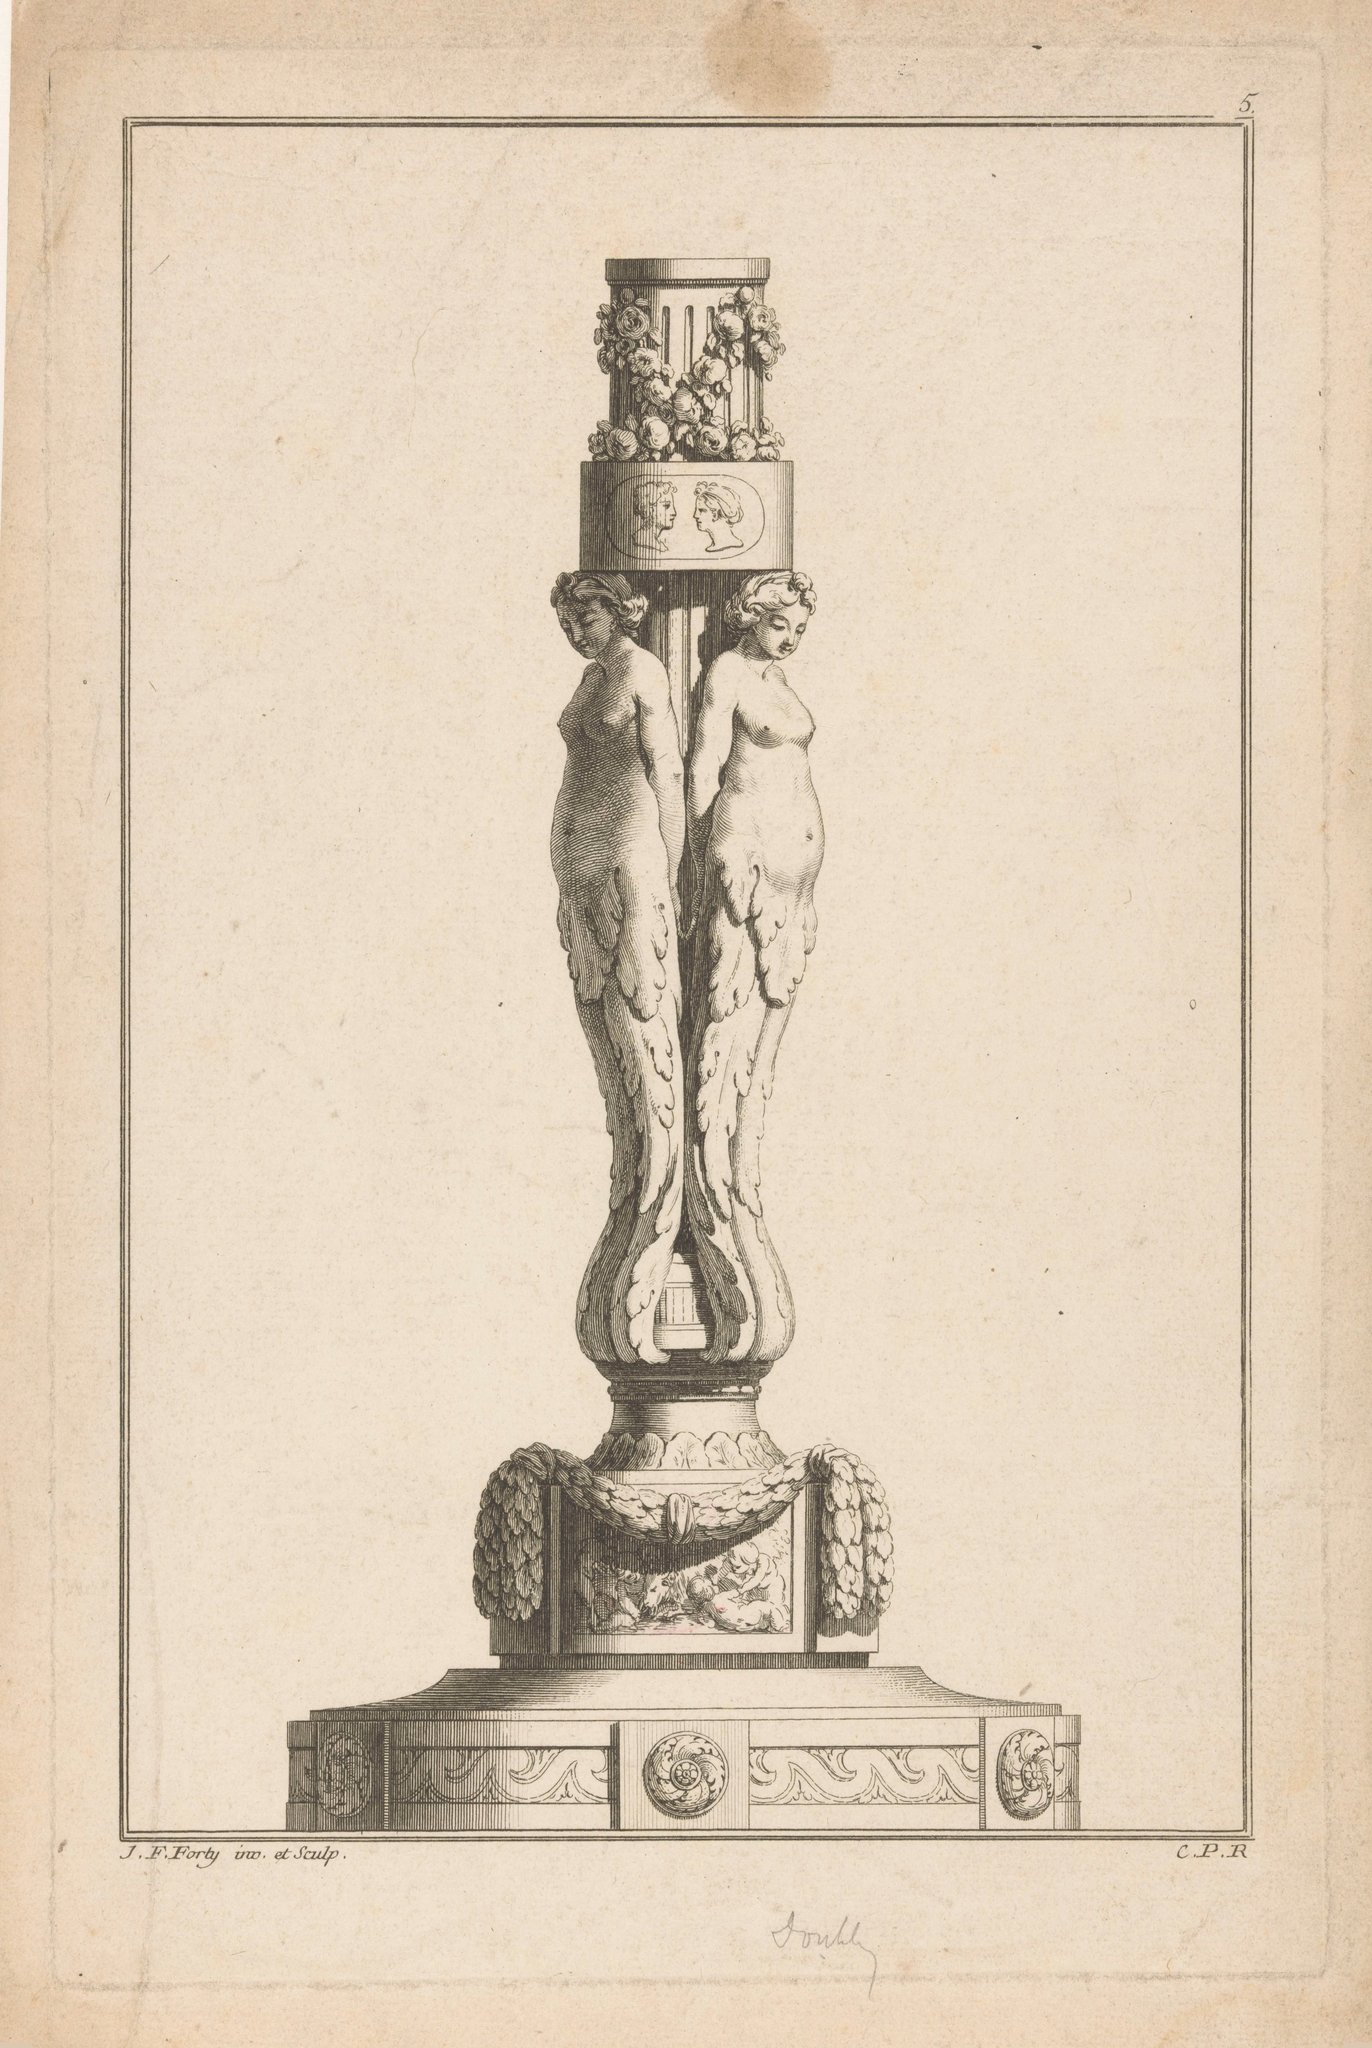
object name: ornament print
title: Oeuvres D'Orfevrerie (...) Livre III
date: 1775-1790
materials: paper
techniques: engraving, etching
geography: paris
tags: chandelier, candelabrum, standing figure - aa - female human figure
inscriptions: collector's mark: Lugt 2228, collector's mark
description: Een geornamenteerde kandelaar met twee naakte vrouwelijke halffiguren.